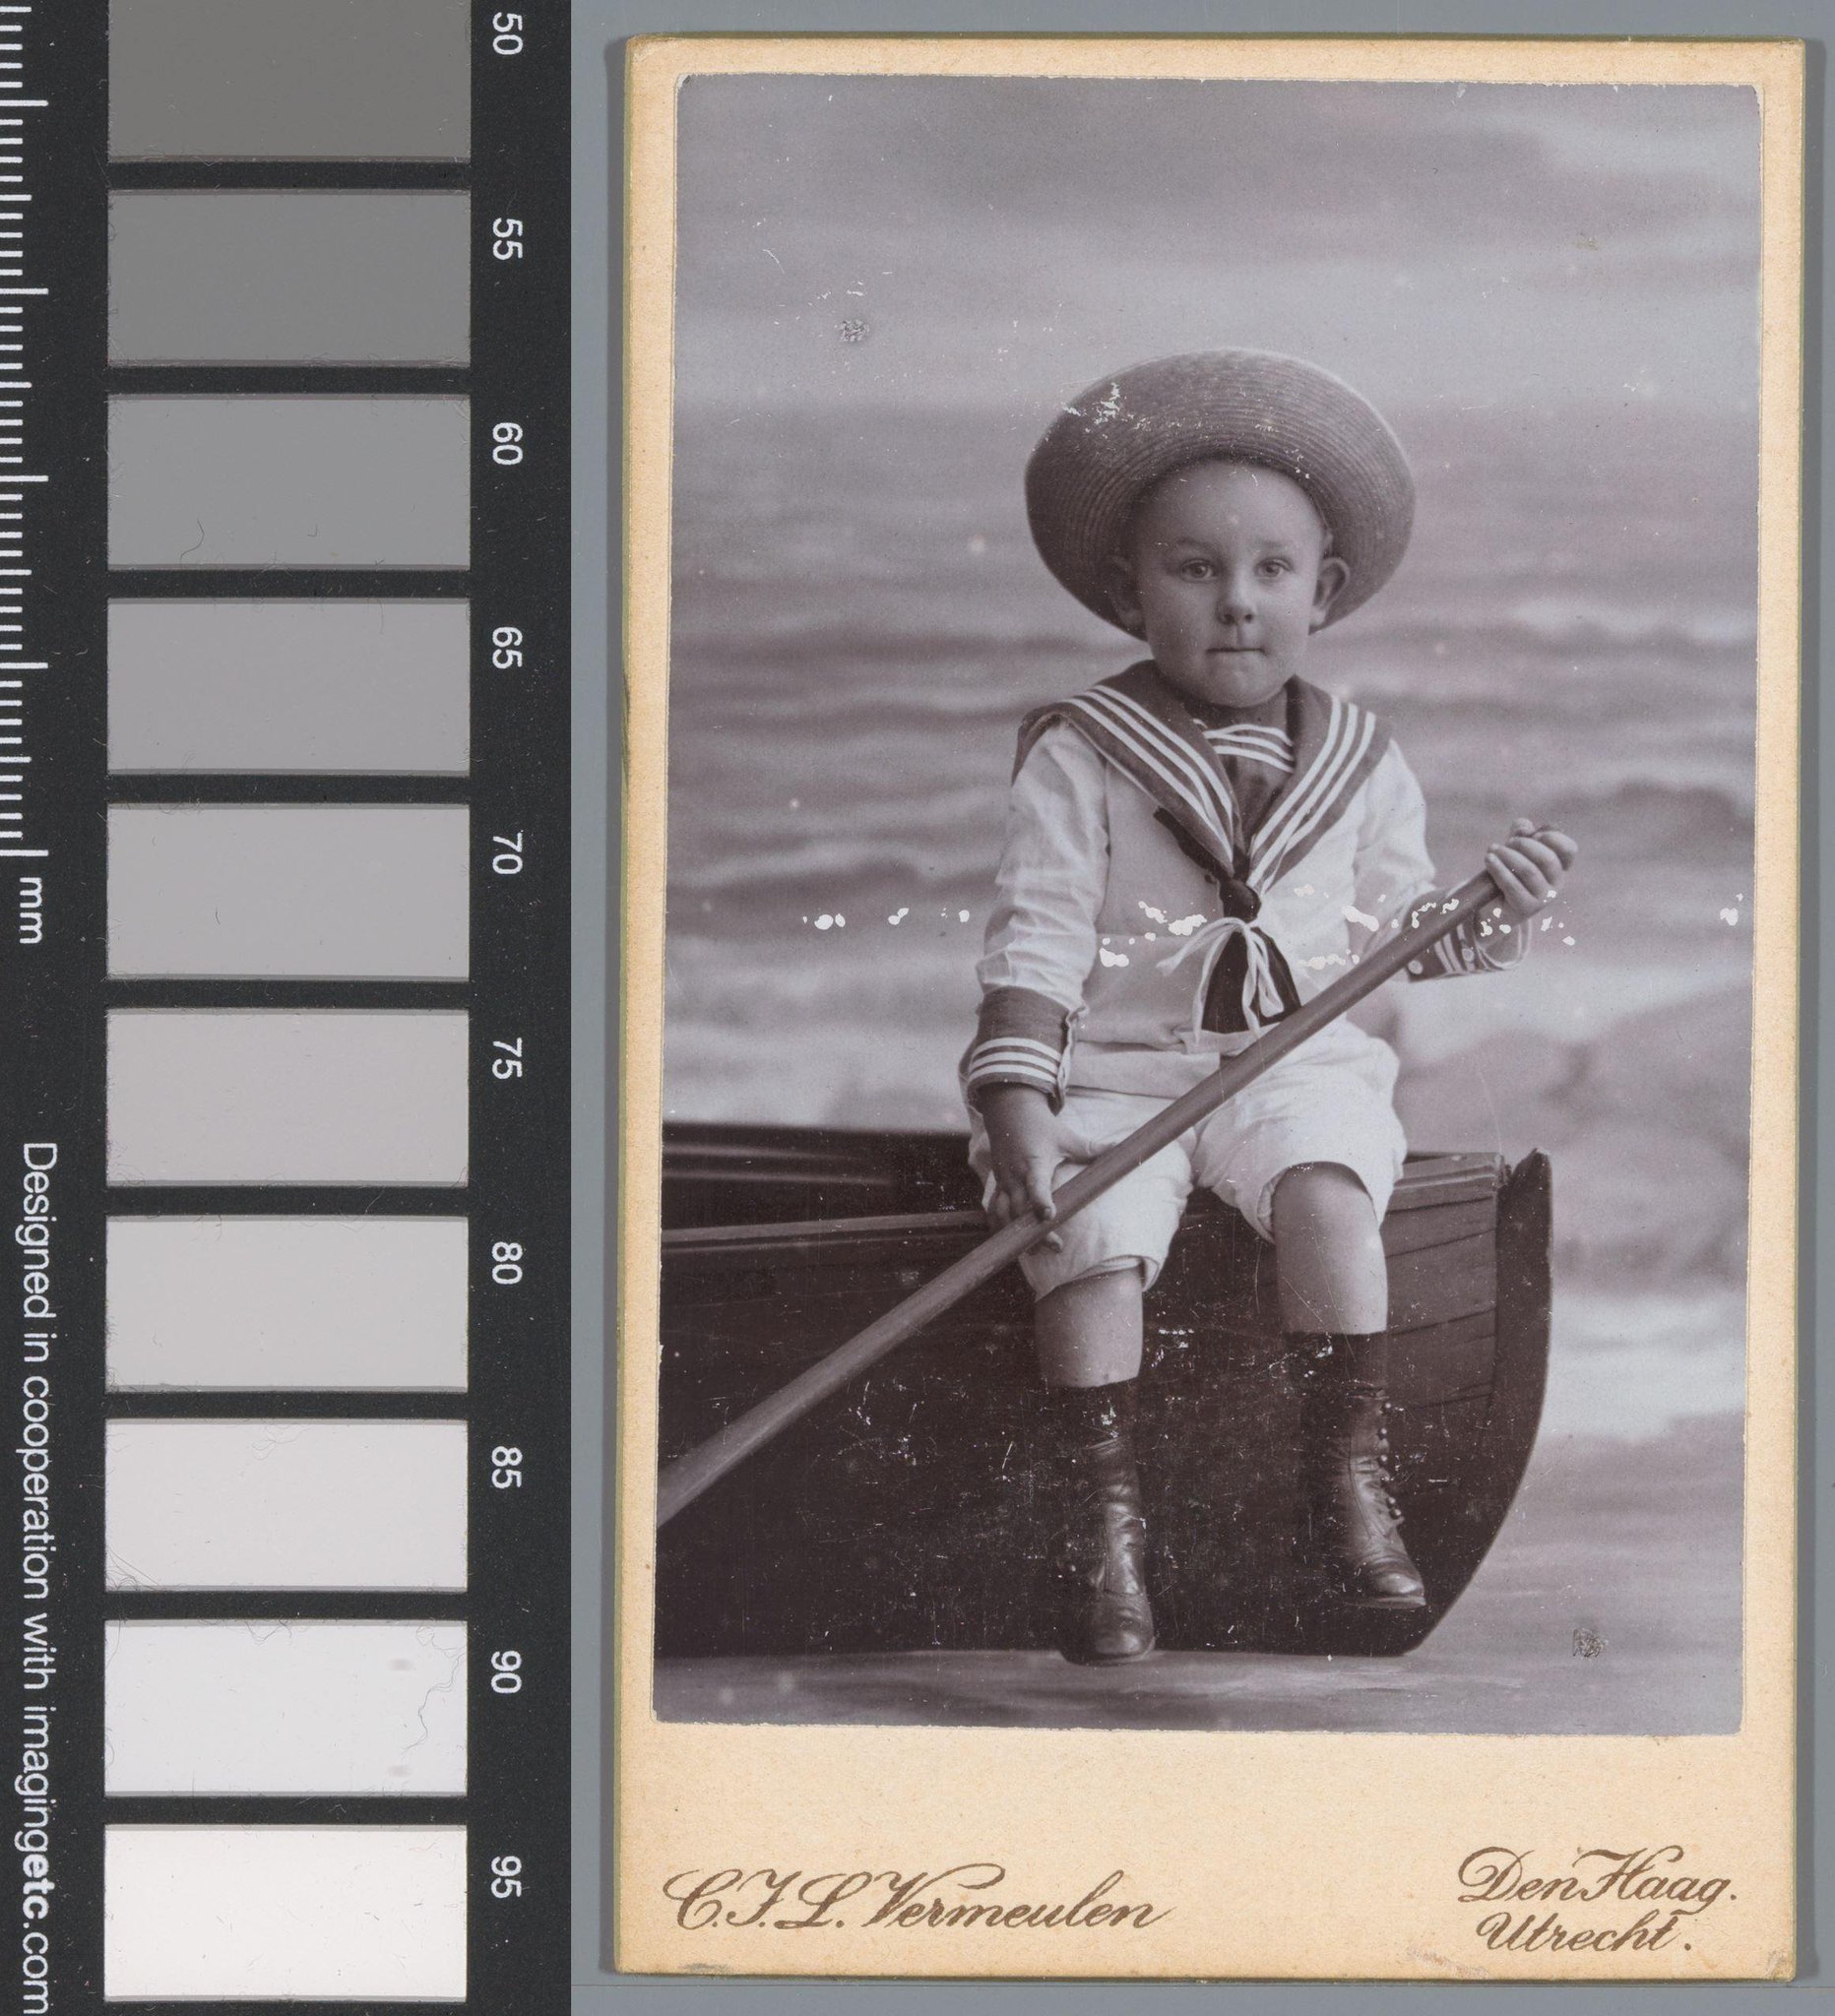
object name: carte de visite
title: Portret van een onbekende jongen met een matrozenpak op een boot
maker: cornelis johannes lodewicus vermeulen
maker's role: fotograaf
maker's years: 1861-1936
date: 1890-1915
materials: cardboard, paper, photographic support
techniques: collodion silver print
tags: boy (child between toddler and youth), sailor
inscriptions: inscription: ‘C.J.L. Vermeulen Atelier voor Moderne Fotografie Den Haag.. Toussaintkade 11. Telefoon 1873.... Utrecht Nieuwe Gracht 50 Telefoon 750....’, name: ‘C.J.L. Vermeulen Den Haag Utrecht.’